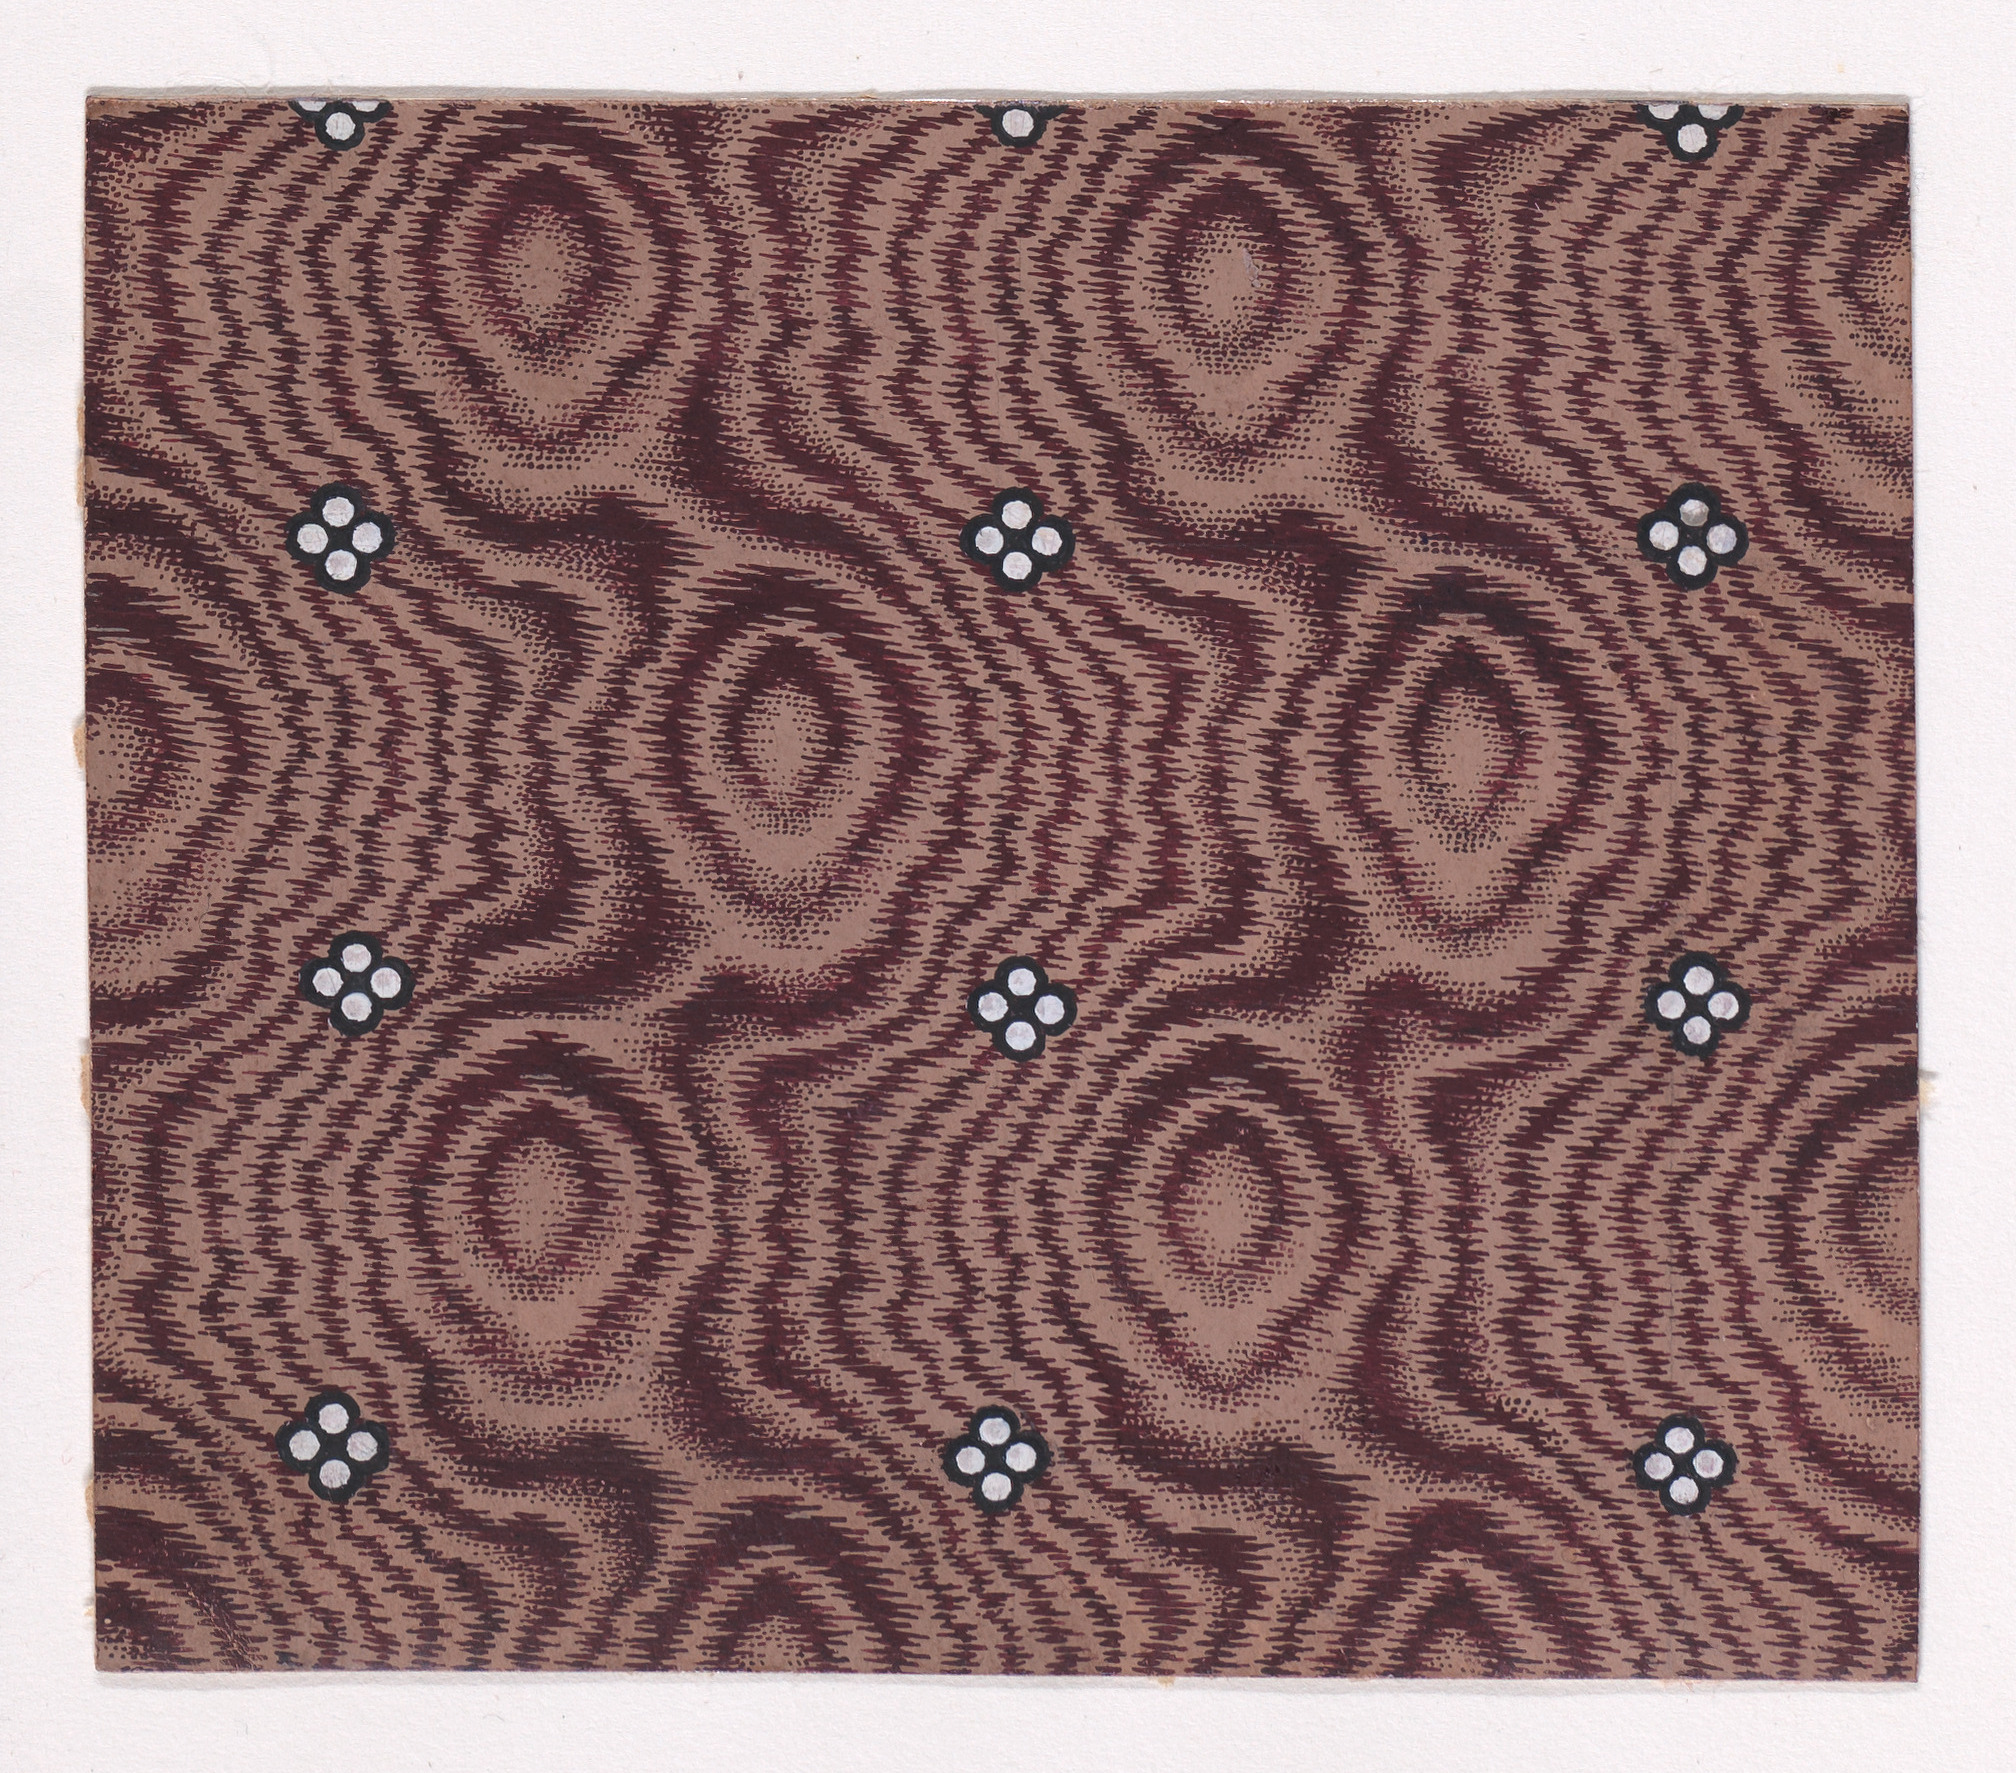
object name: drawing ornament architecture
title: Textile Design with Rows of Quatrefoils of Pearls over an Abstract Background Simulating Tie-Dye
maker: anonymous, alsatian, 19th century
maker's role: artist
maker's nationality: alsatian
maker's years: 1800-1900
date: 1840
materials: gouache